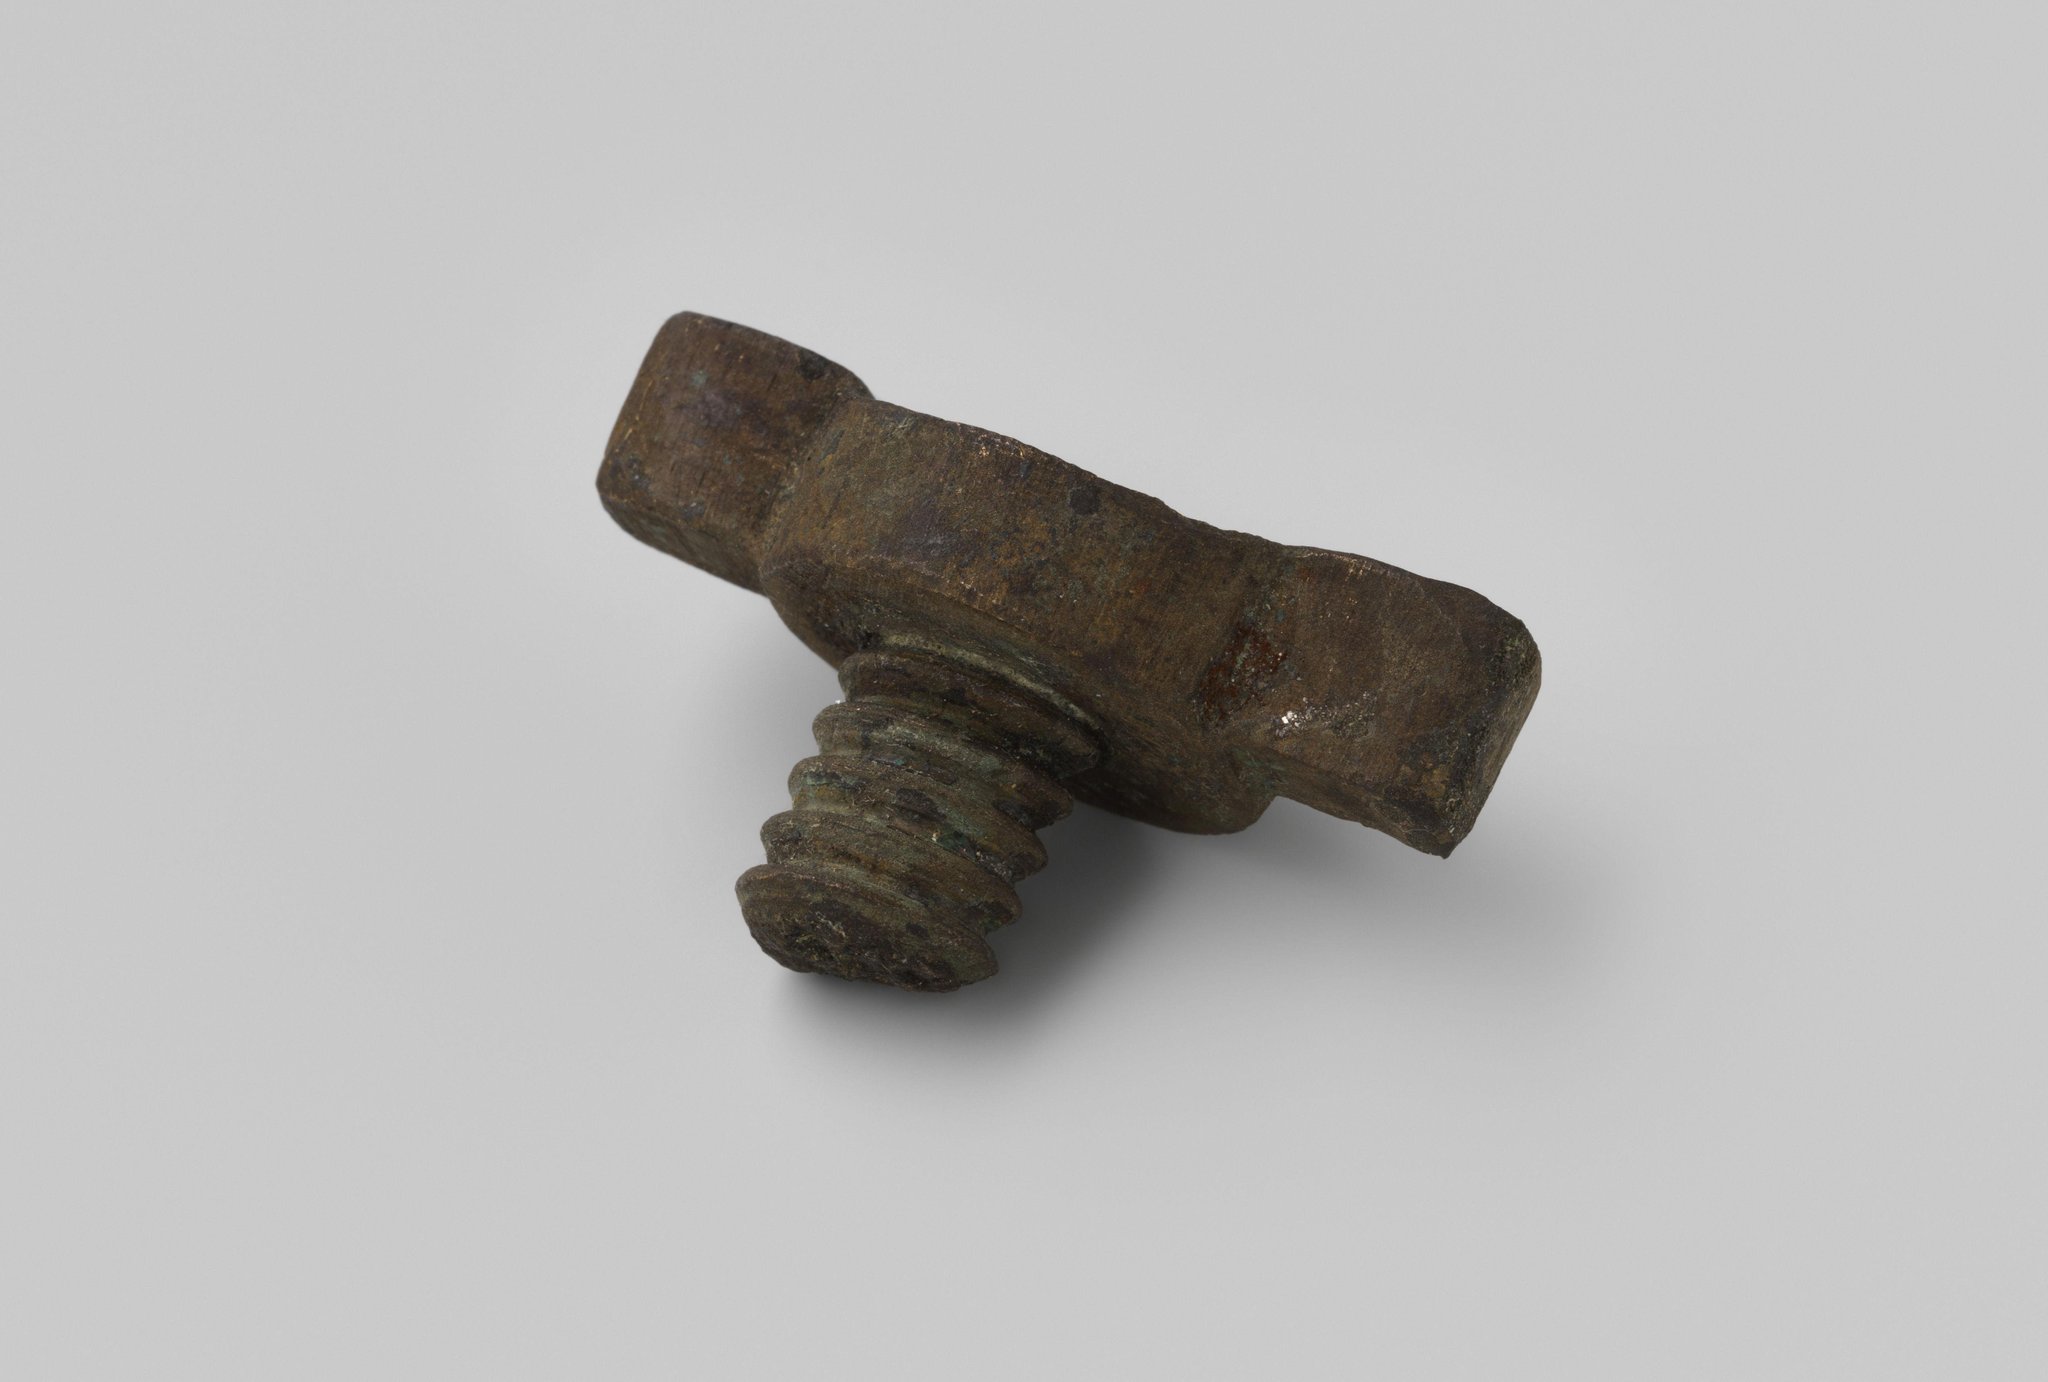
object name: nut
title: Moer uit het wrak van de Oost-Indiëvaarder Hollandia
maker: Anonymous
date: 1743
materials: copper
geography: netherlands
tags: verenigde oostindische compagnie, hollandia (schip), annet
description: Nuts; circular flat ring, with 2 vertical wings on diametrically opposite outer sides, central circular hole threaded inside, with fragm of threaded shaft.